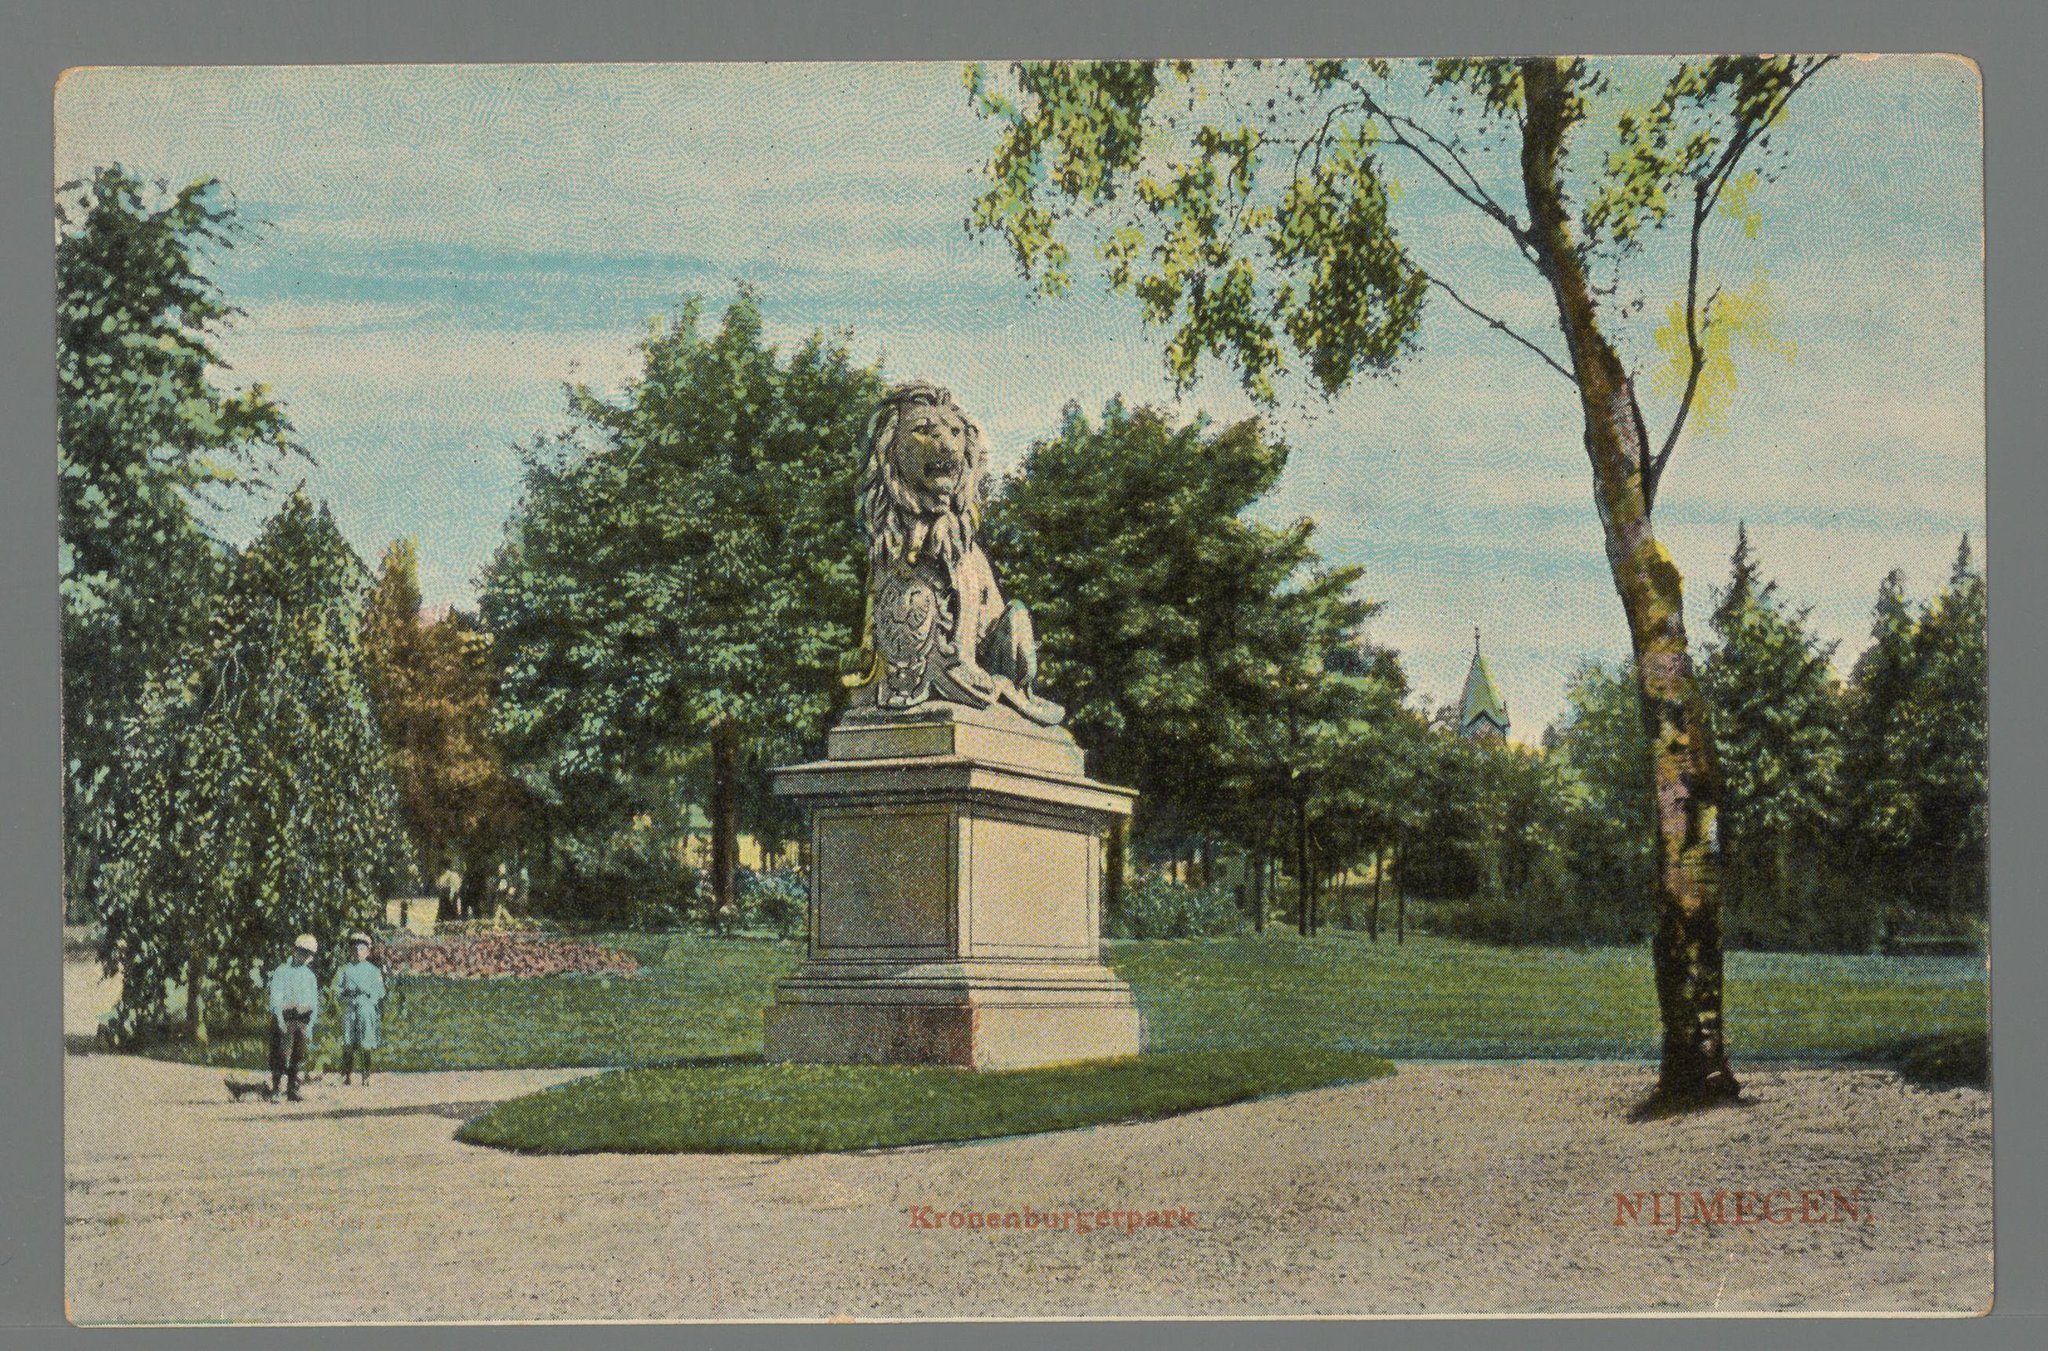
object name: photomechanical print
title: Kronenburgerpark. Nijmegen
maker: Anonymous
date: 1905-1919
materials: cardboard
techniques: lithograph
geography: nijmegen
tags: park, monument, statue